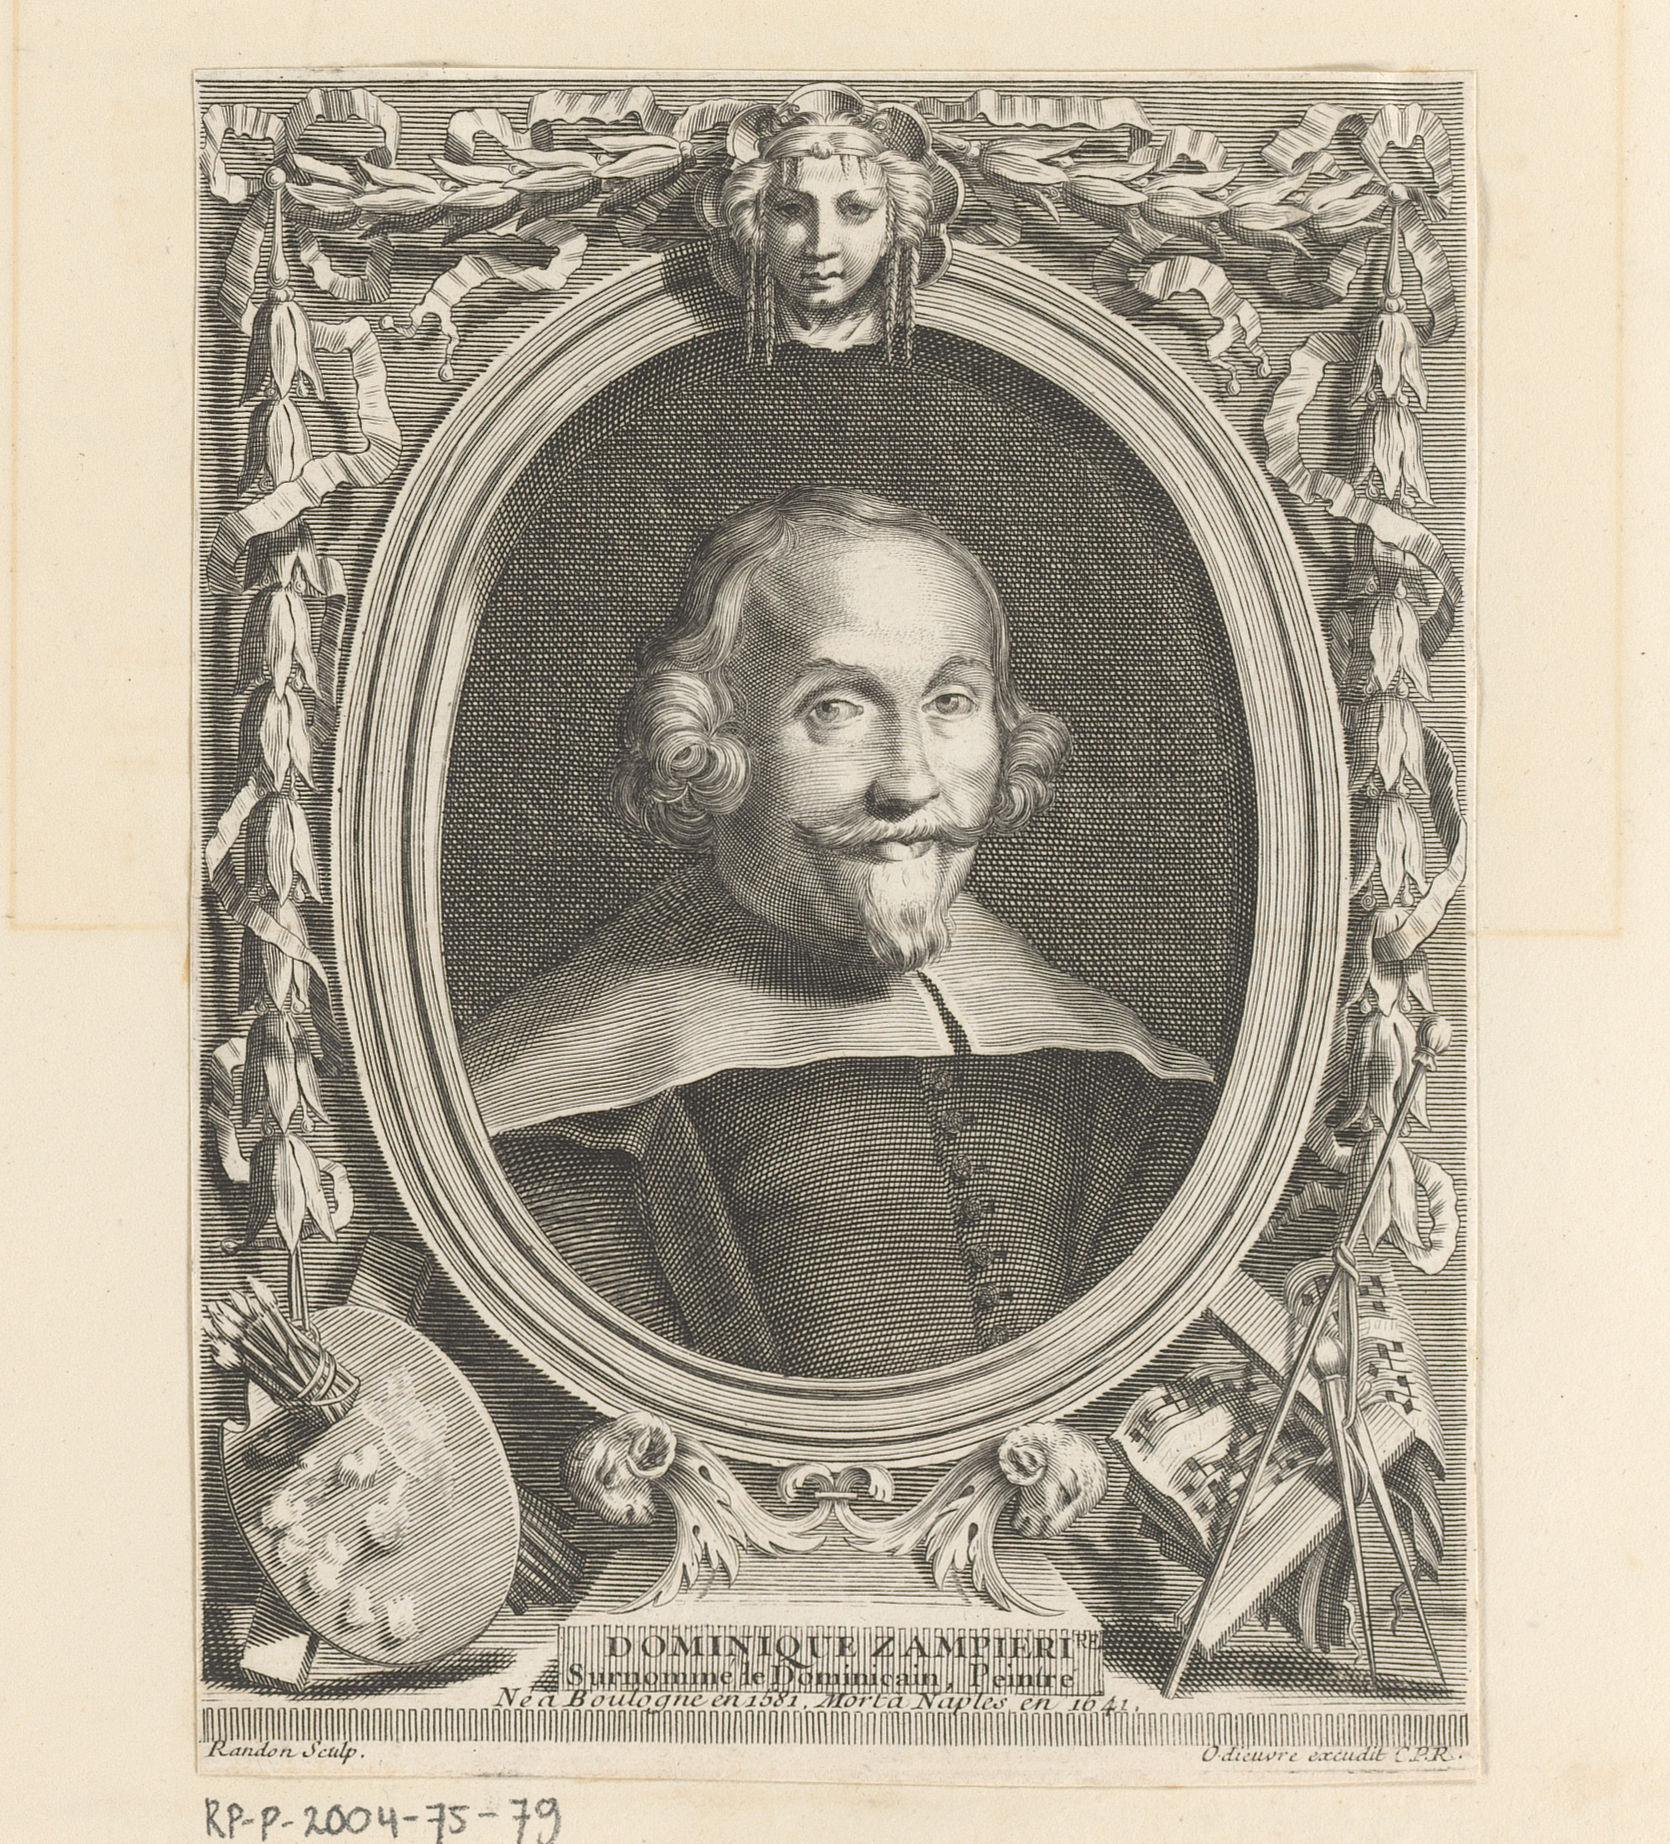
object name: album leaf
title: Dominique Zampieri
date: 1777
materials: paper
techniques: engraving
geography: paris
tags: naples, painter, draughtsman, domenichino, historical persons, portrait, self-portrait of painter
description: Prent uit: Dreux du Radier, Jean-François. L'Europe illustré, contenant l'histoire abregée des souverains, des princes, des prélats, des ministres, (...) en Europe: dans le XVe. siècle compris, jusqu'à présent. 6 dln. Parijs: Jean-Luc Nyon, 1777, dl. 6. Eerdere delen van dit boek zijn uitgegeven door Odieuvre & Breton tussen 1755 en 1765. Een tweede editie kwam uit in 1775 en het laatste, uitgeven door Jean-Luc Nyon, in 1777. De samensteller heeft deze prent in het album geplakt als illustratie bij: Pilkington, Matthew en Johann Heinrich Füssli. A dictionary of painters, from the revival of the art to the present period. 4 dln. Londen: John Crowder, 1805, dl. 4, p. 634.